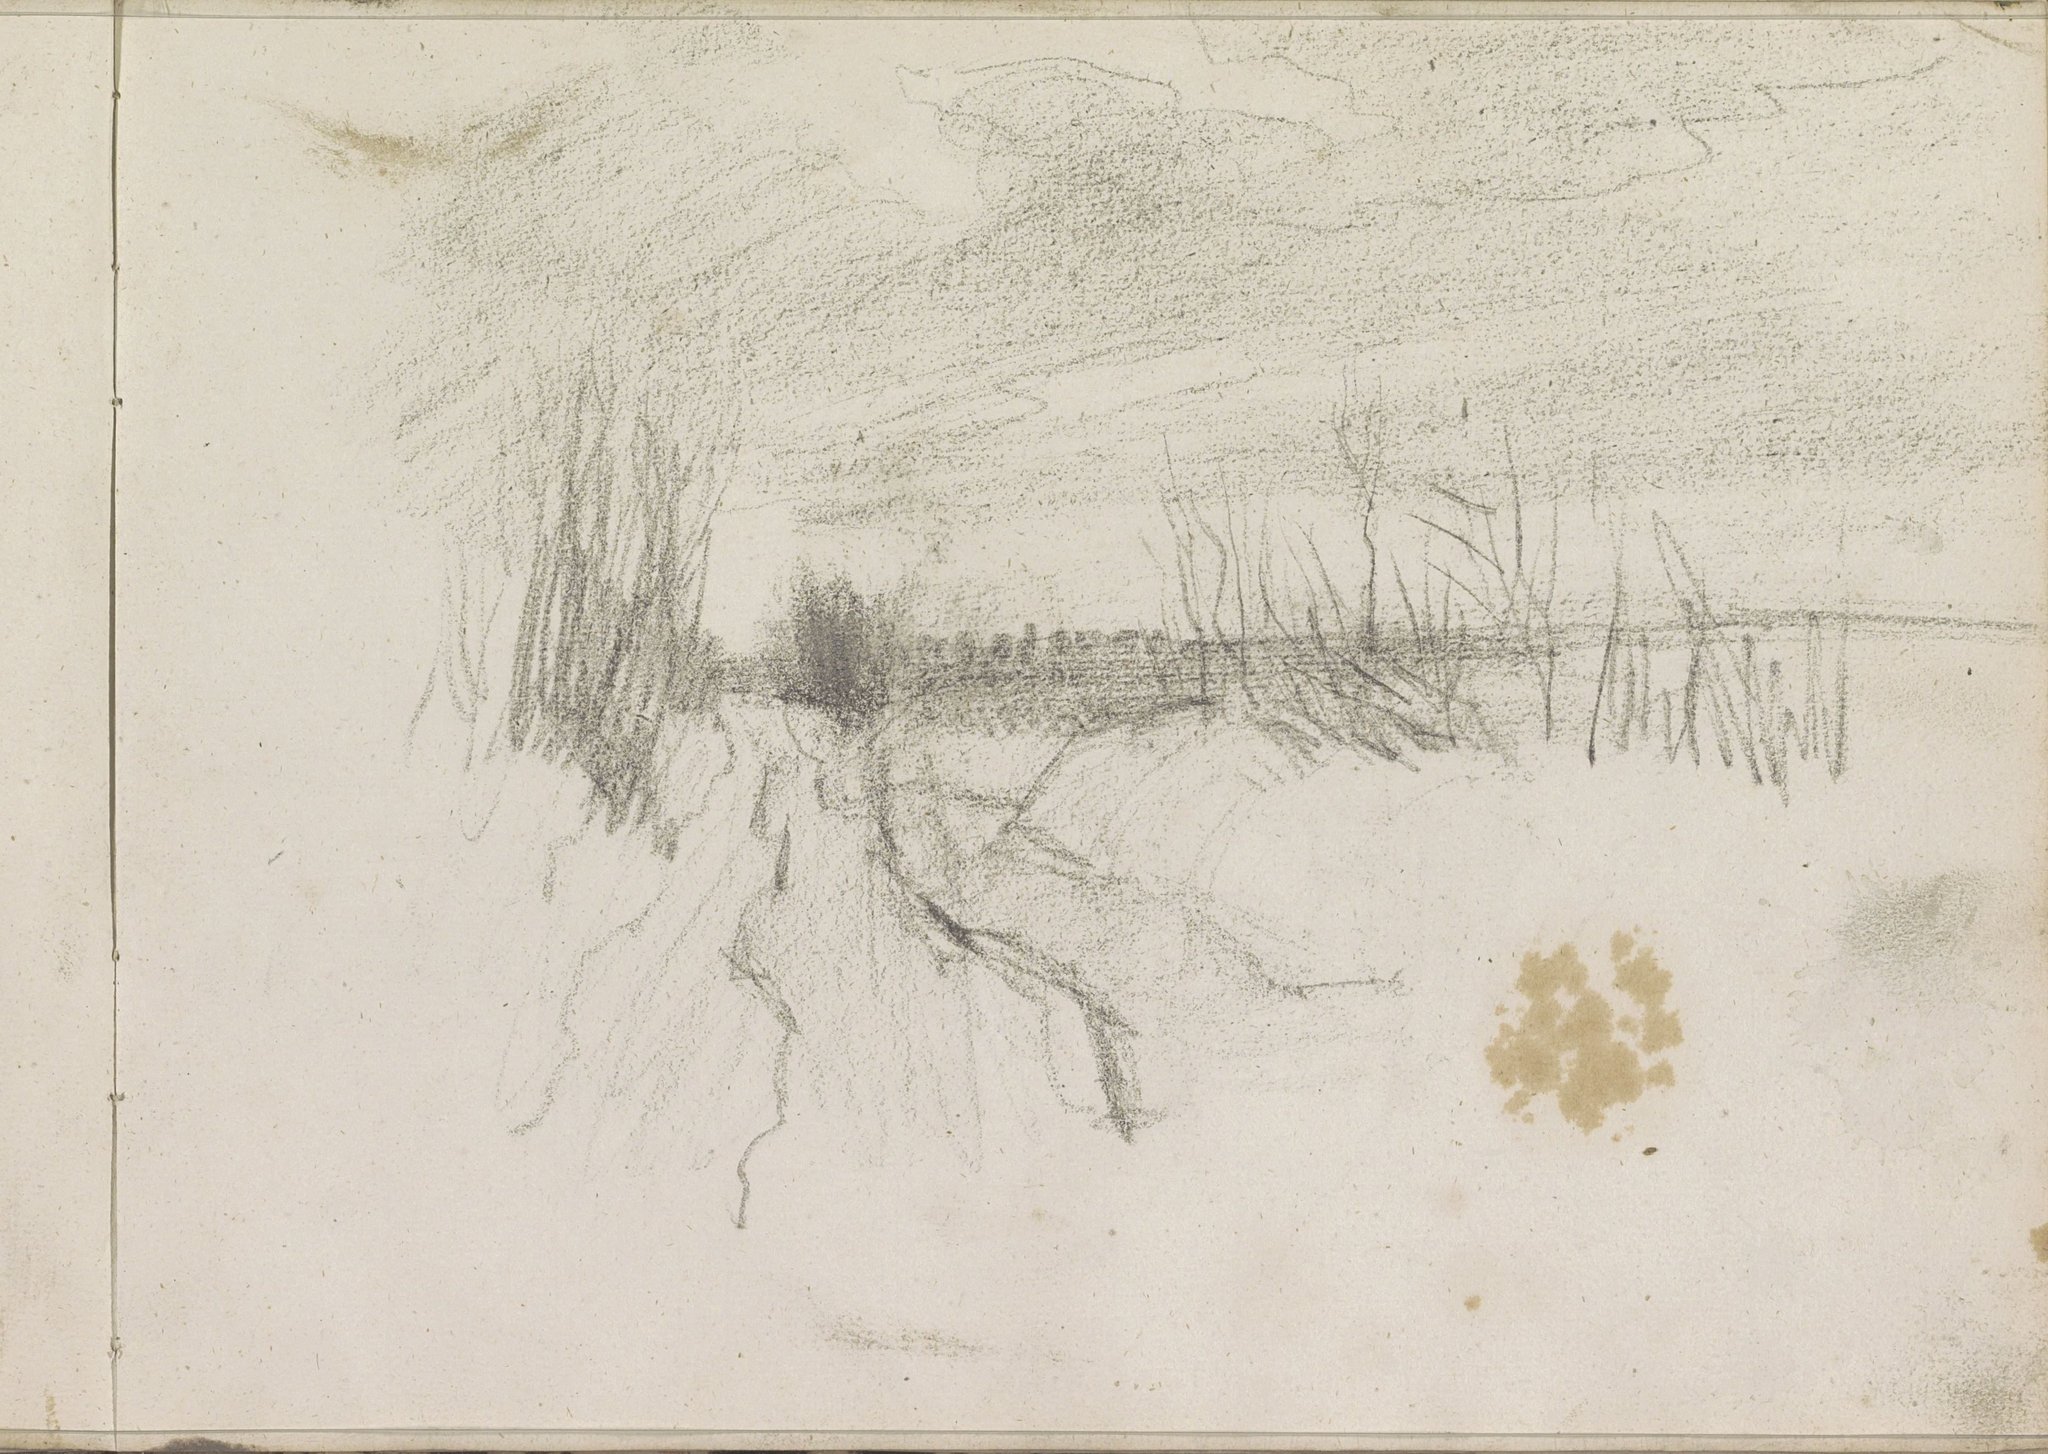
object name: sketchbook leaf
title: Landschap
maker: anton mauve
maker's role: draughtsman, painter, print maker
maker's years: 1838-1888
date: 1848-1888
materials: chalk, paper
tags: landscapes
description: Blad 11 recto uit een schetsboek met 34 bladen.